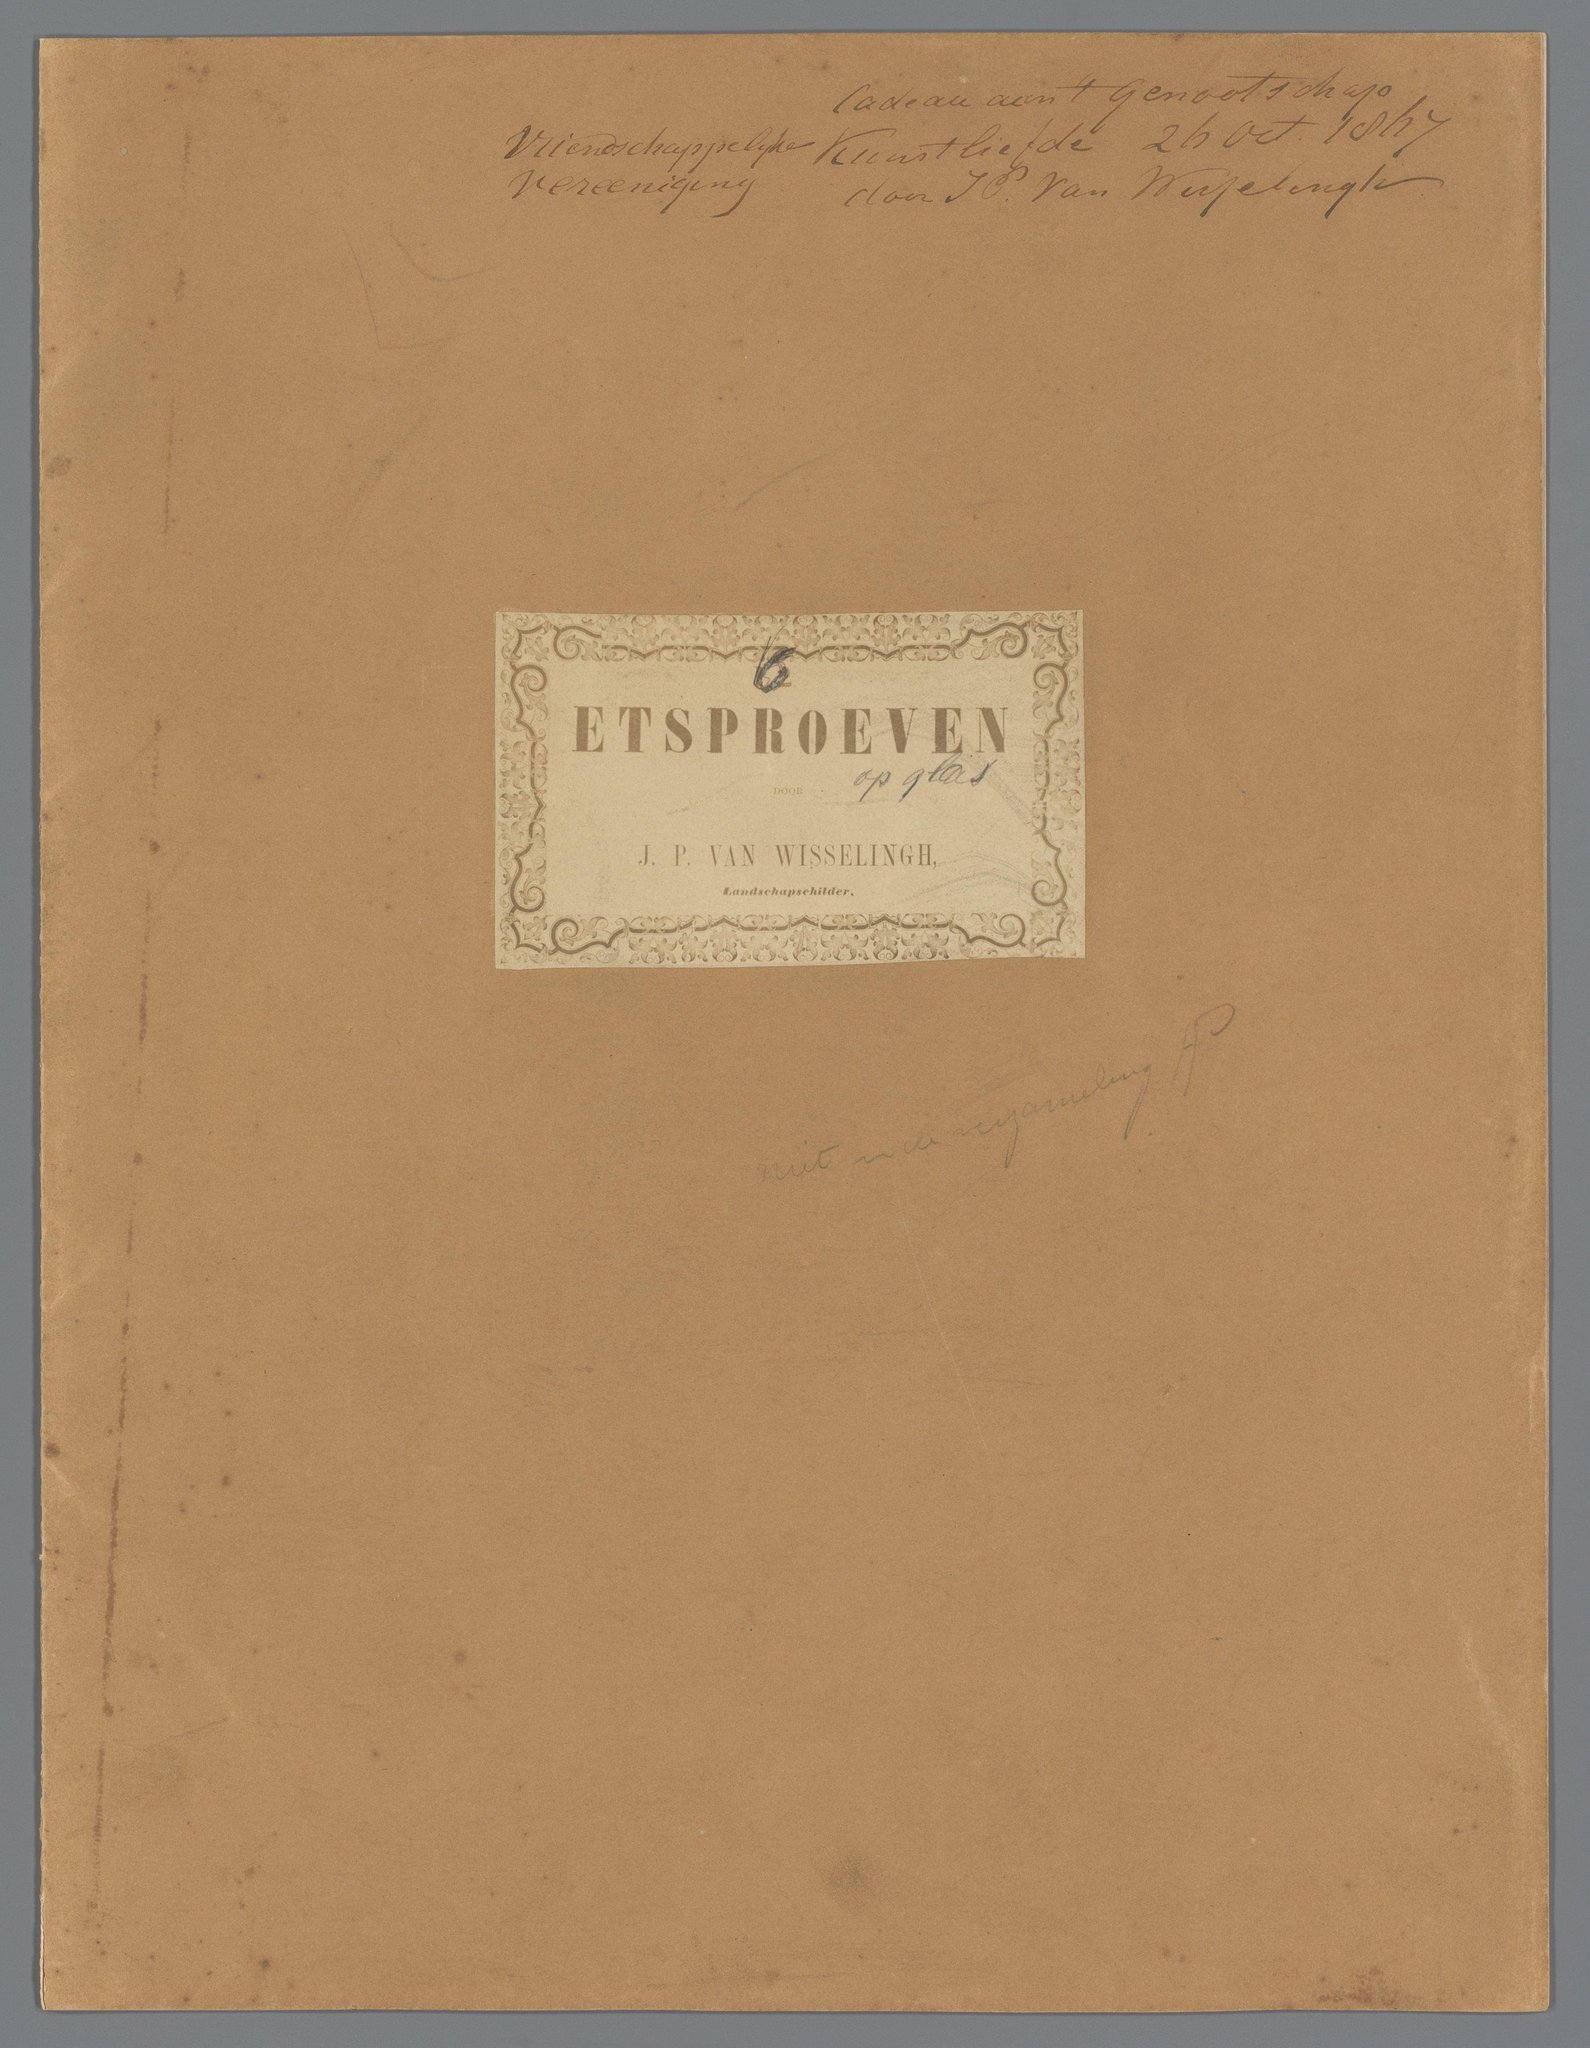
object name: wrapper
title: Omslag met zeven fotoreproducties van etsproeven van Johannes Pieter van Wisselingh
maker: Anonymous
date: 1867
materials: cardboard, paper, photographic support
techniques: albumen print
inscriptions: collector's mark: ‘R.P.K.’, annotation: ‘Cadeau aan 't genootschap/ Vriendschappelijke kunstliefde 26 oct. 1867/ vereeniging door J.P. van Wisselingh’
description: Omslag met zeven reproducties van prenten.